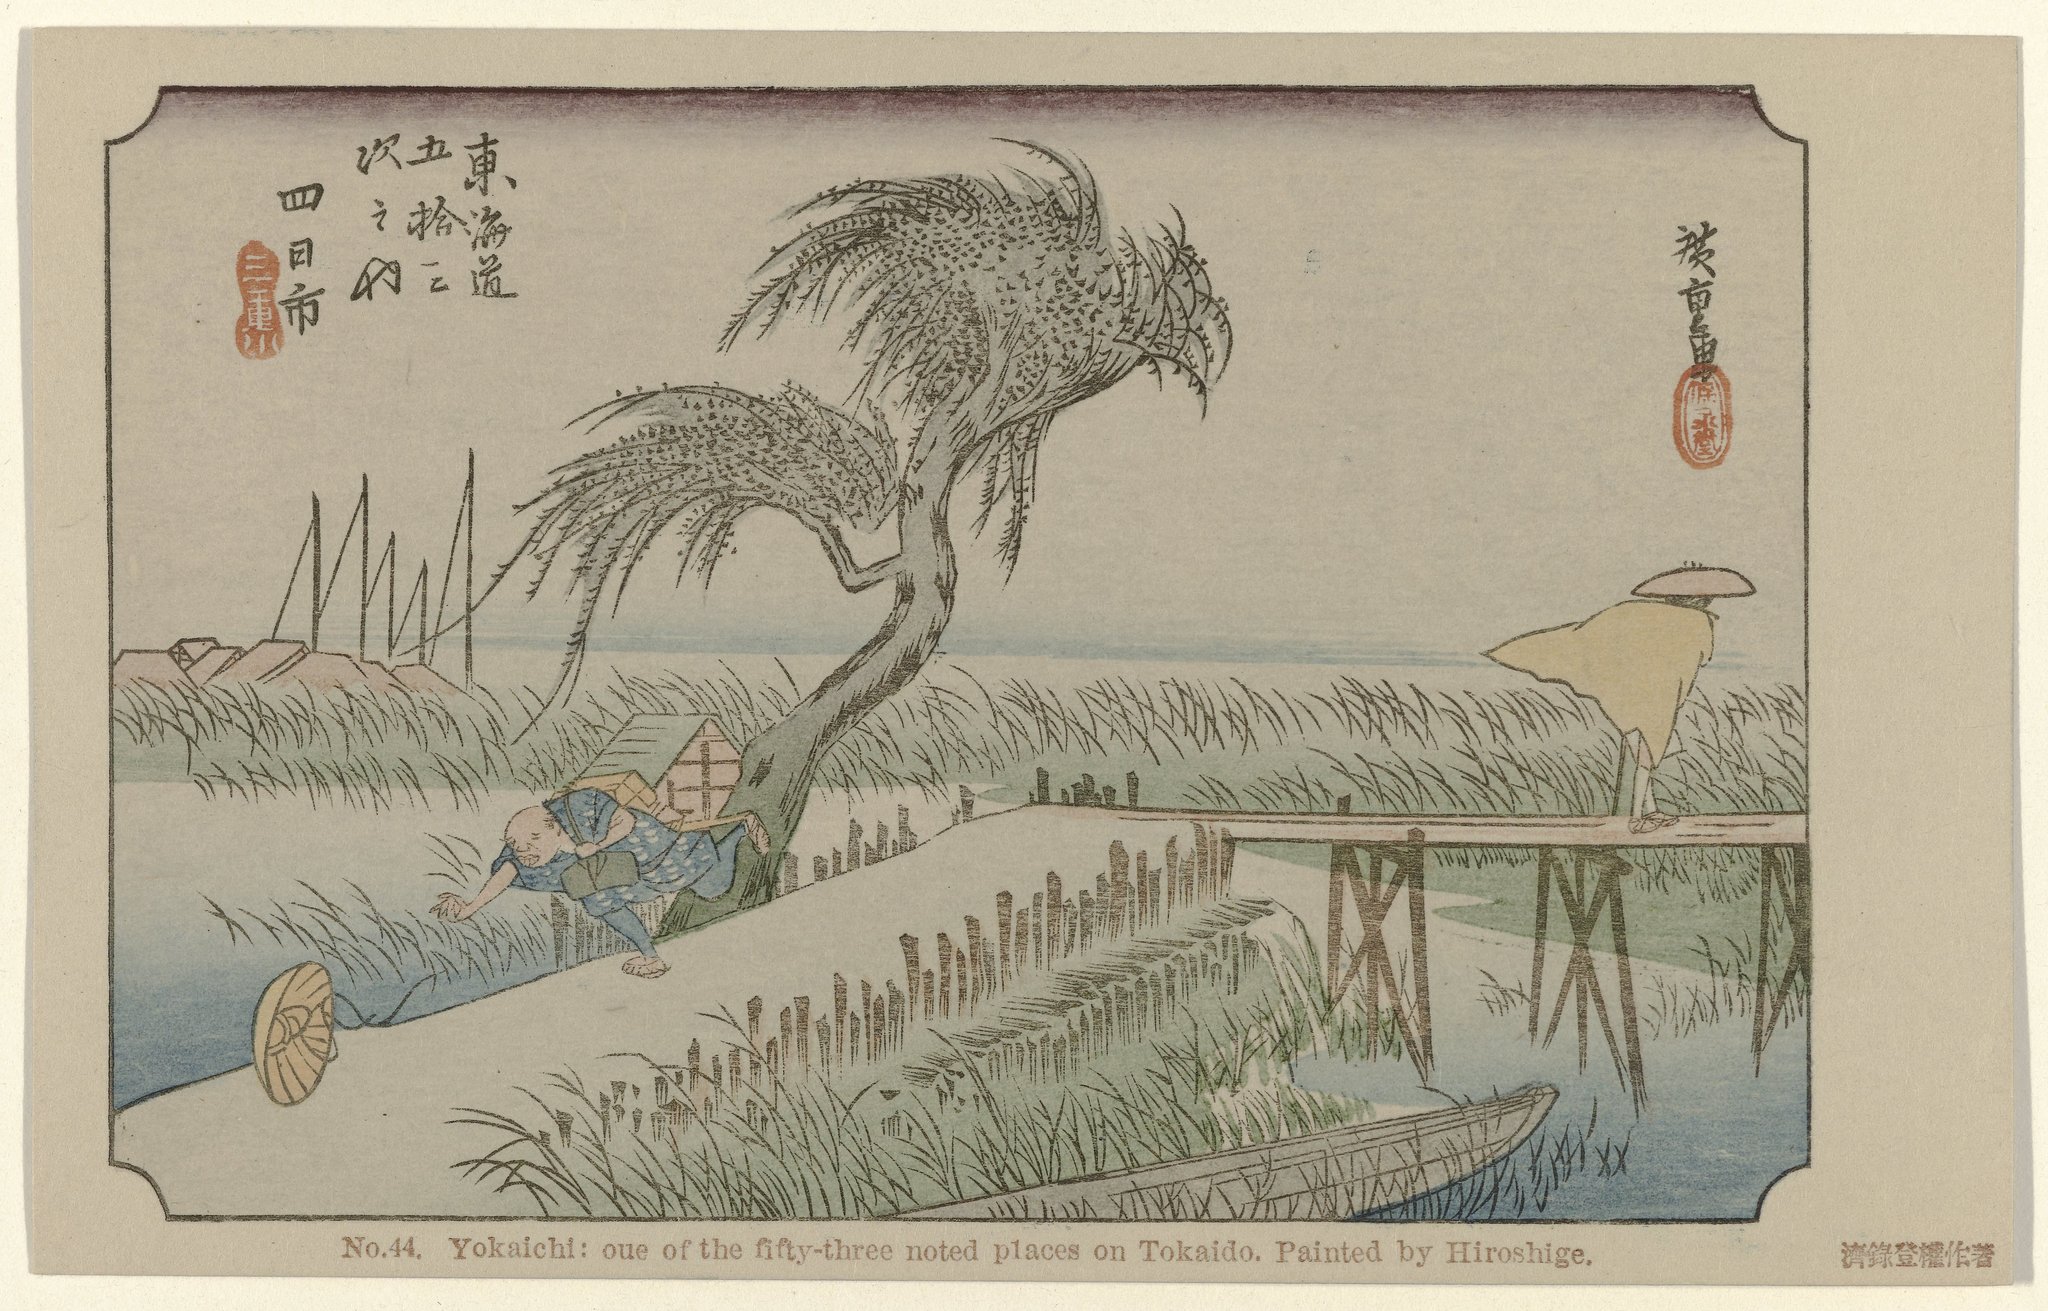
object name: ansichtkaart, prentbriefkaart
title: Yokaichi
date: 1906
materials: cardboard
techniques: woodcut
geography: japan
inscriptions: date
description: In een storm rent een man achter zijn hoed aan terwijl een andere man de rivier oversteekt.